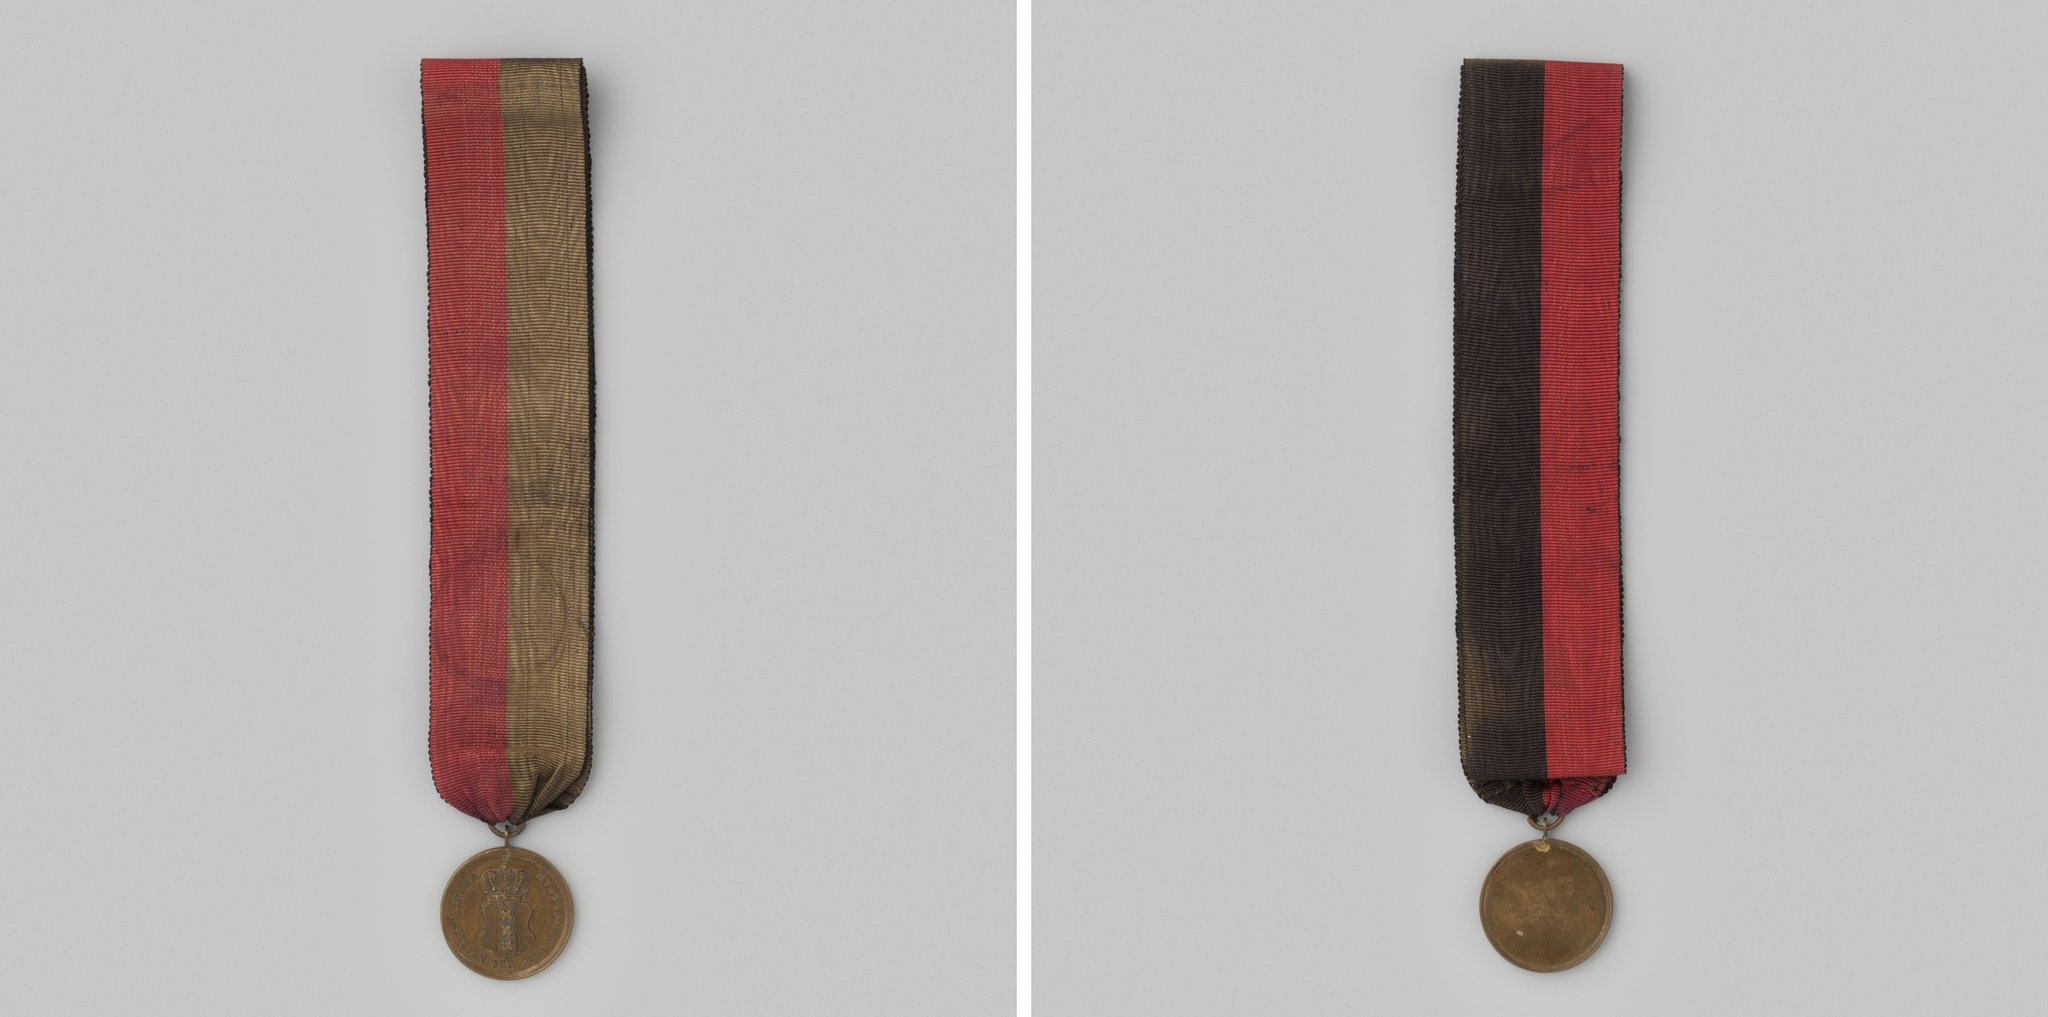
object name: medal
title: Draagpenning der buurtcommissarissen te Amsterdam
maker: Anonymous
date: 1850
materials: bronze, textile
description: Bronzen draagpenning met oog, ring en lint.